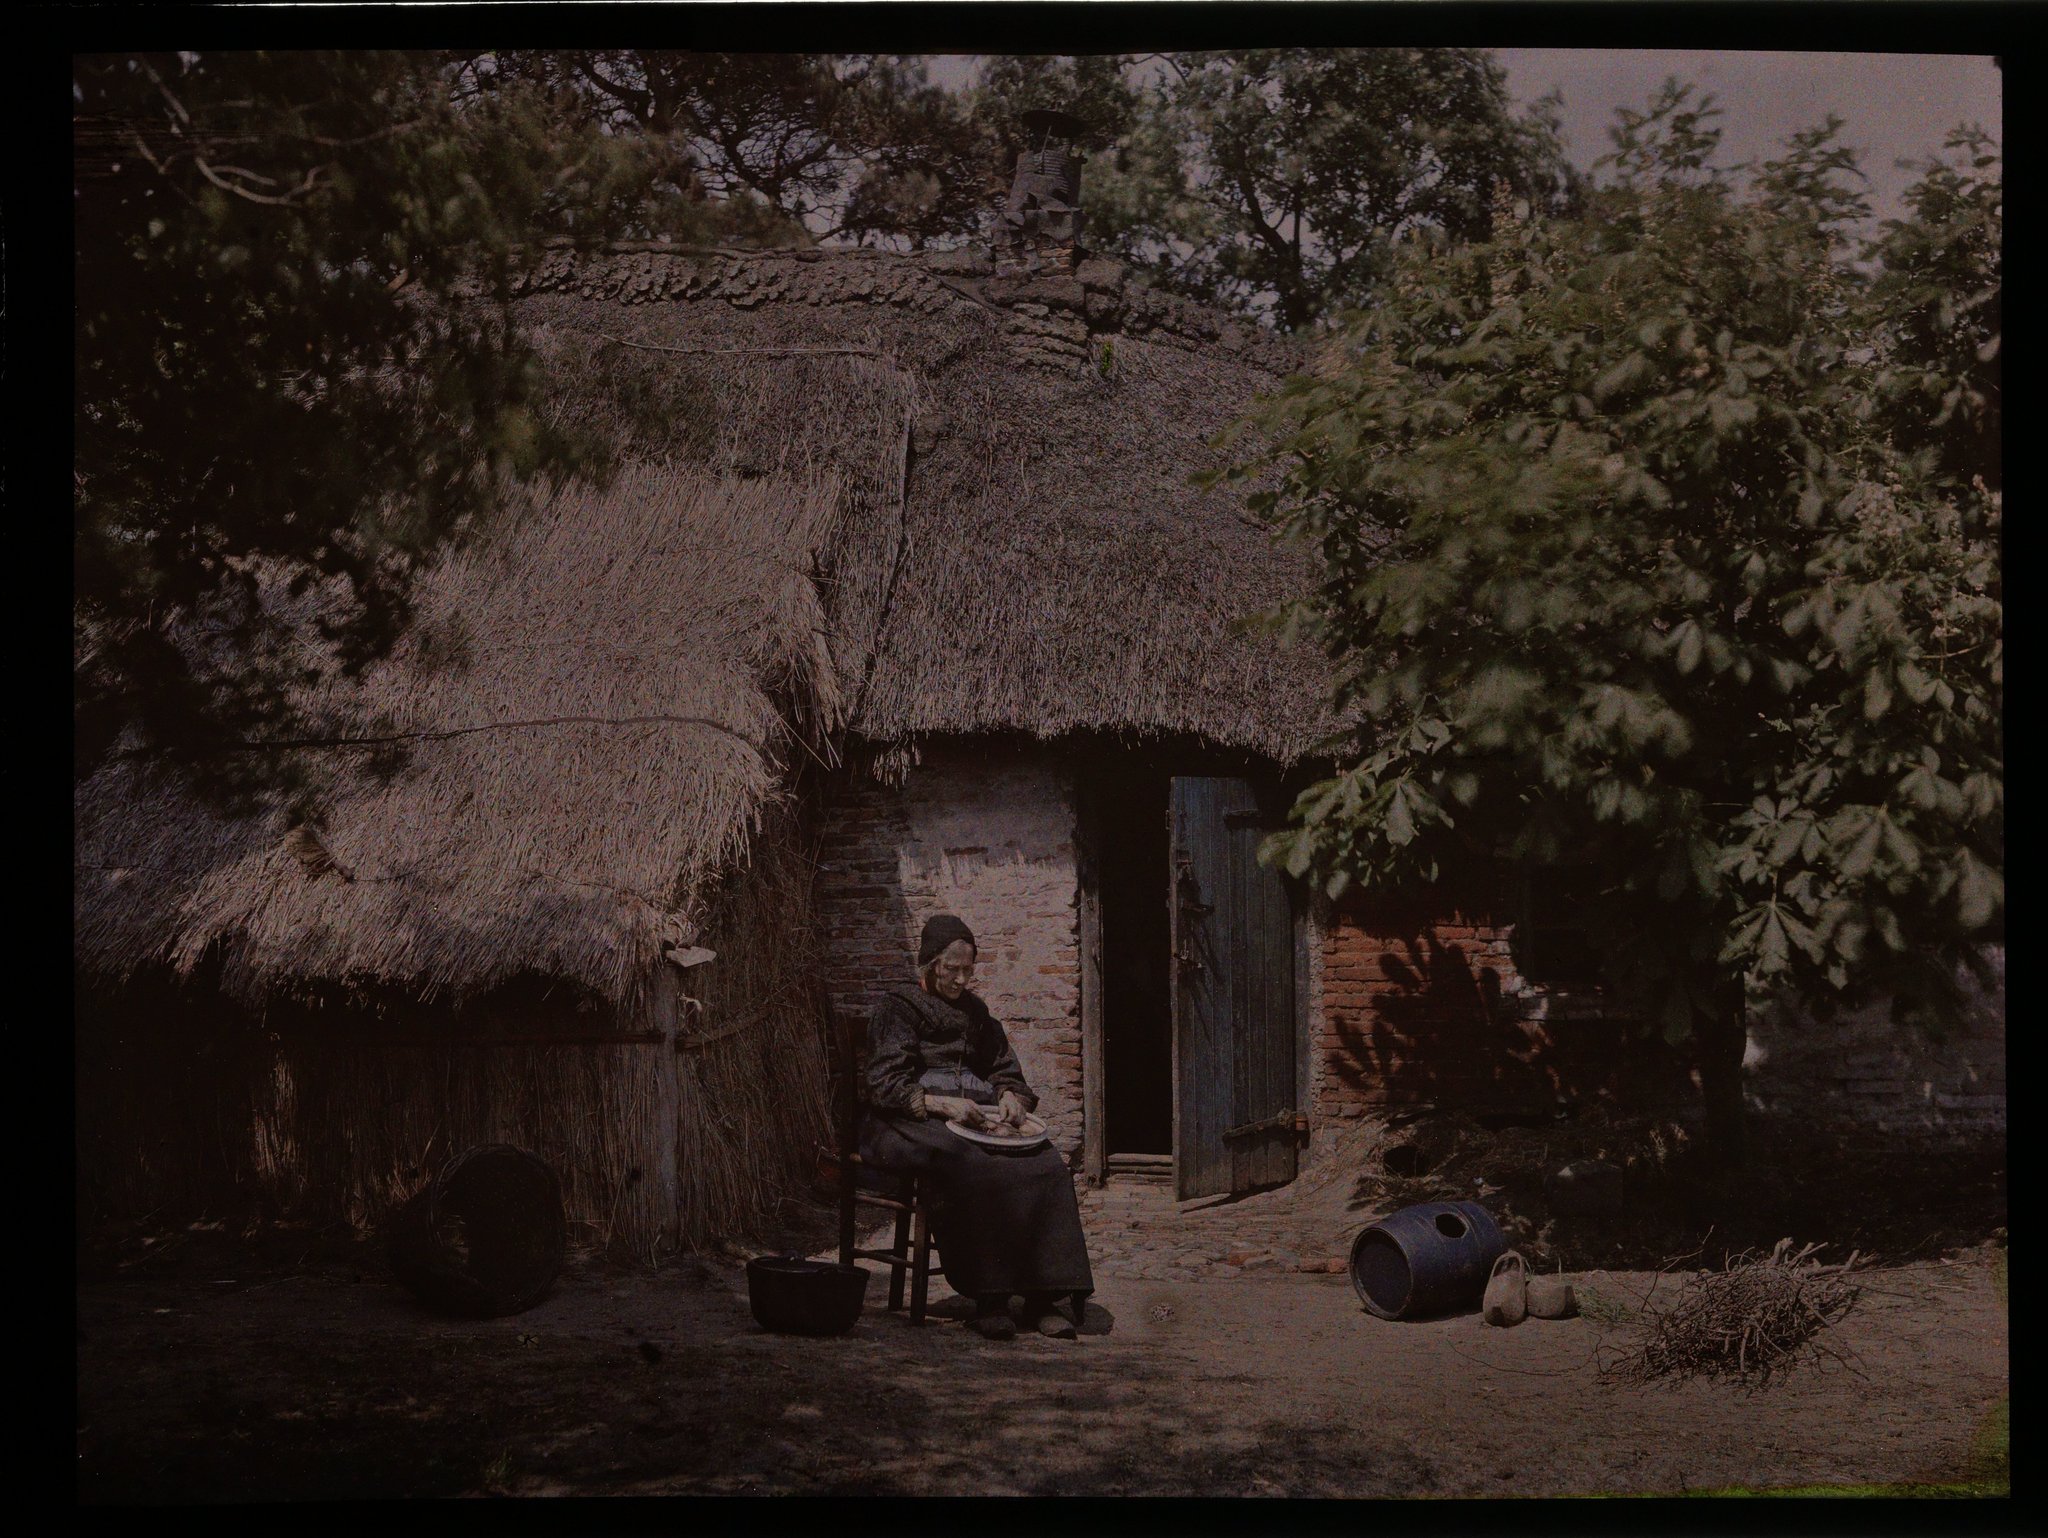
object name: photograph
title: Vrouw op erf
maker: Anonymous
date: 1907-1935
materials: glass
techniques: autochrome process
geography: netherlands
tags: netherlands